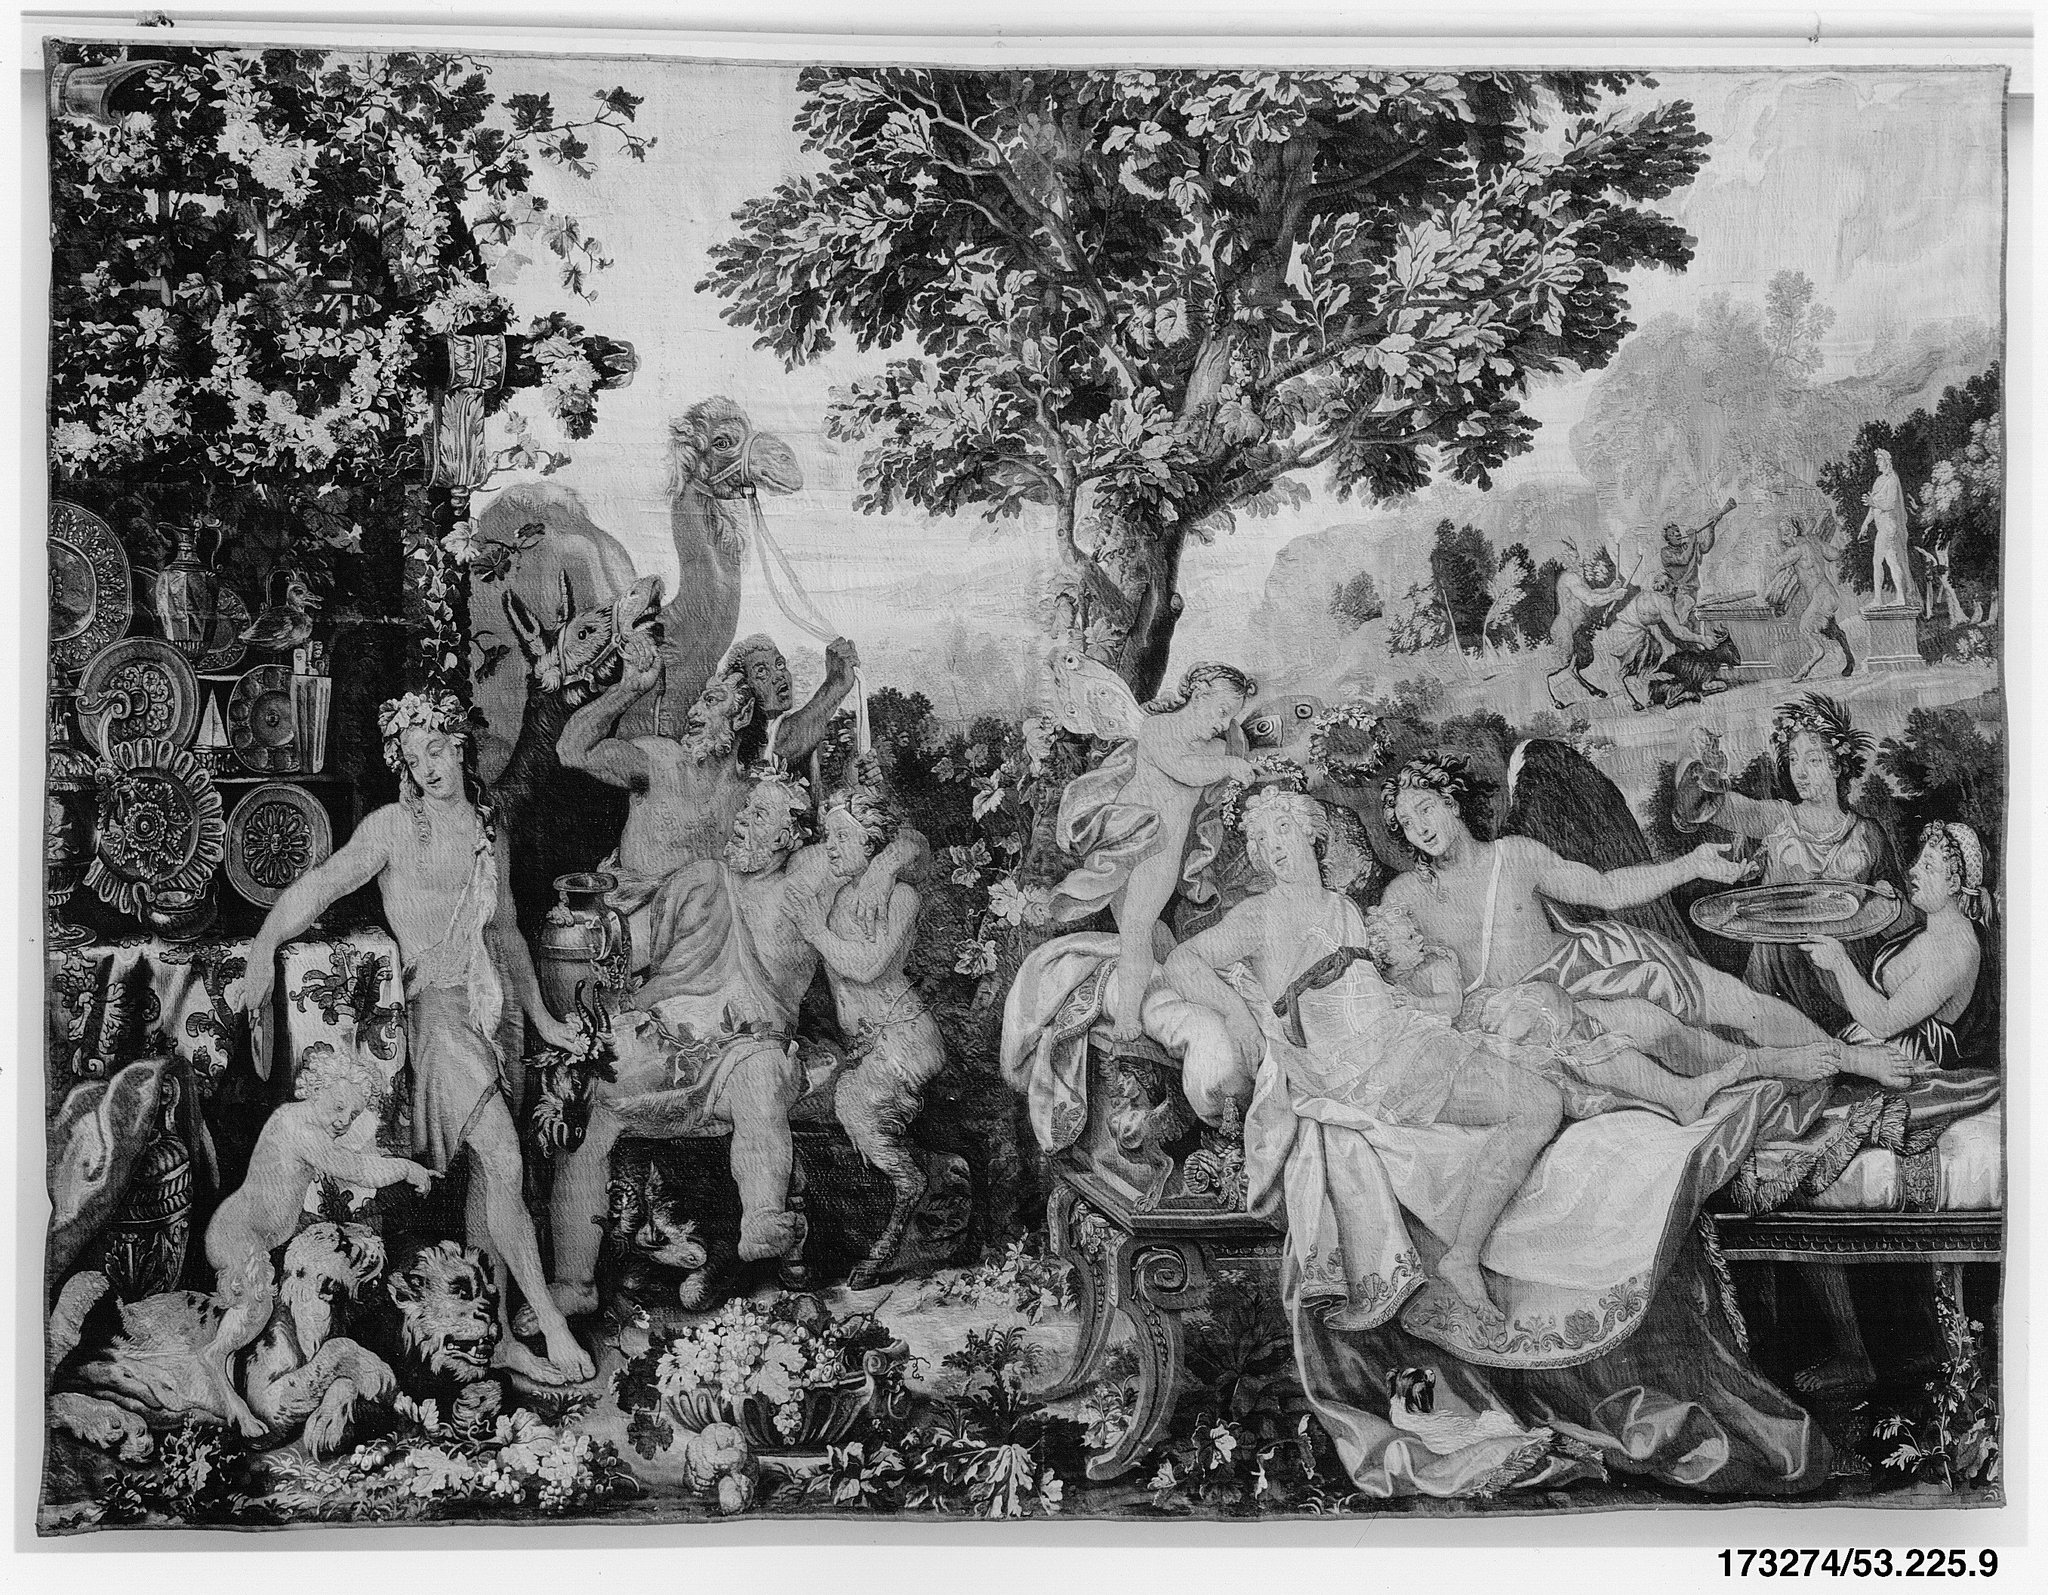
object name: tapestry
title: The Festival of Psyche, with Bacchus from a set of Mythological Subjects after Giulio Romano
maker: giulio romano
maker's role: artist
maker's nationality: italian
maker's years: 1499-1546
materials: metal thread, silk, wool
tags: women,bacchus,camels,lions